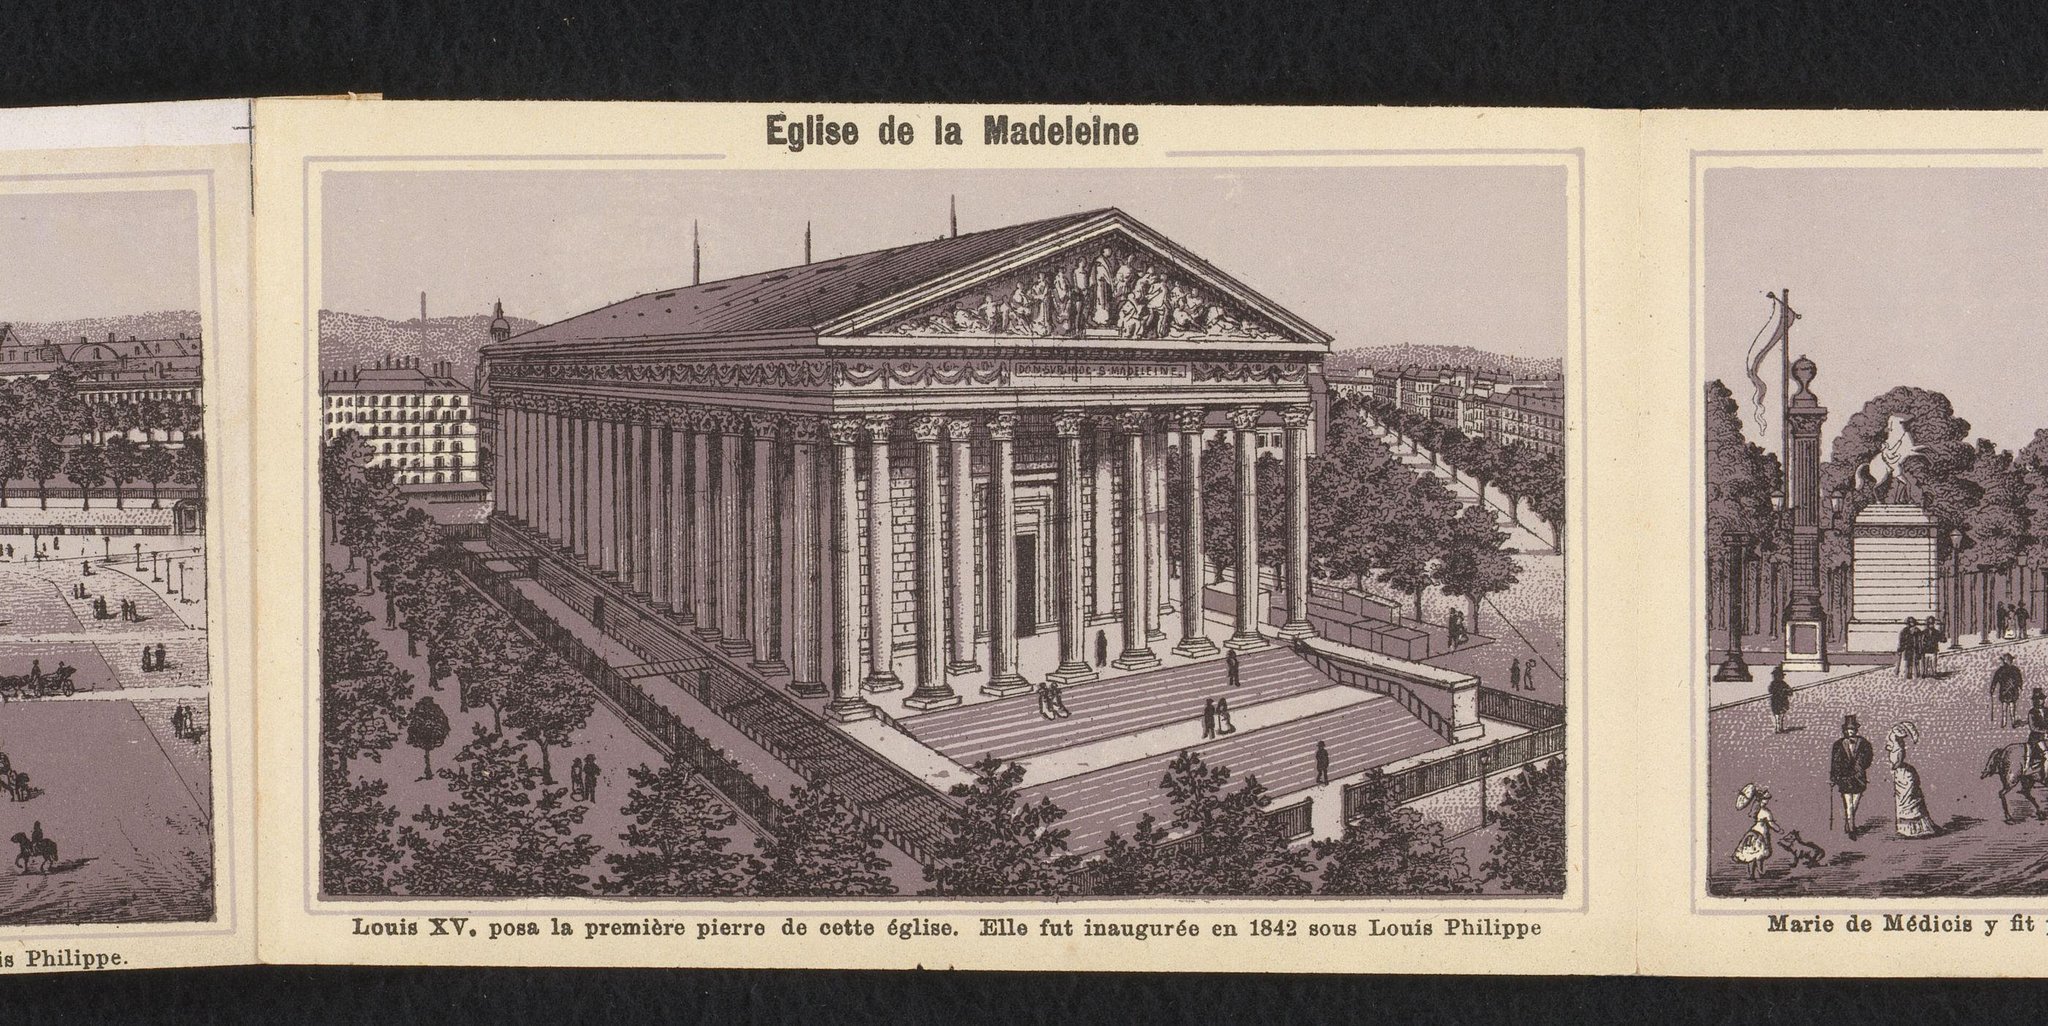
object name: print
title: Eglise de la Madeleine. Louis XV posa la première pierre de cette église (...)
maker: Anonymous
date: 1890-1910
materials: cardboard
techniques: lithograph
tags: church (exterior), city-view, and landscape with man-made constructions (+ city(-scape) with figures, staffage)